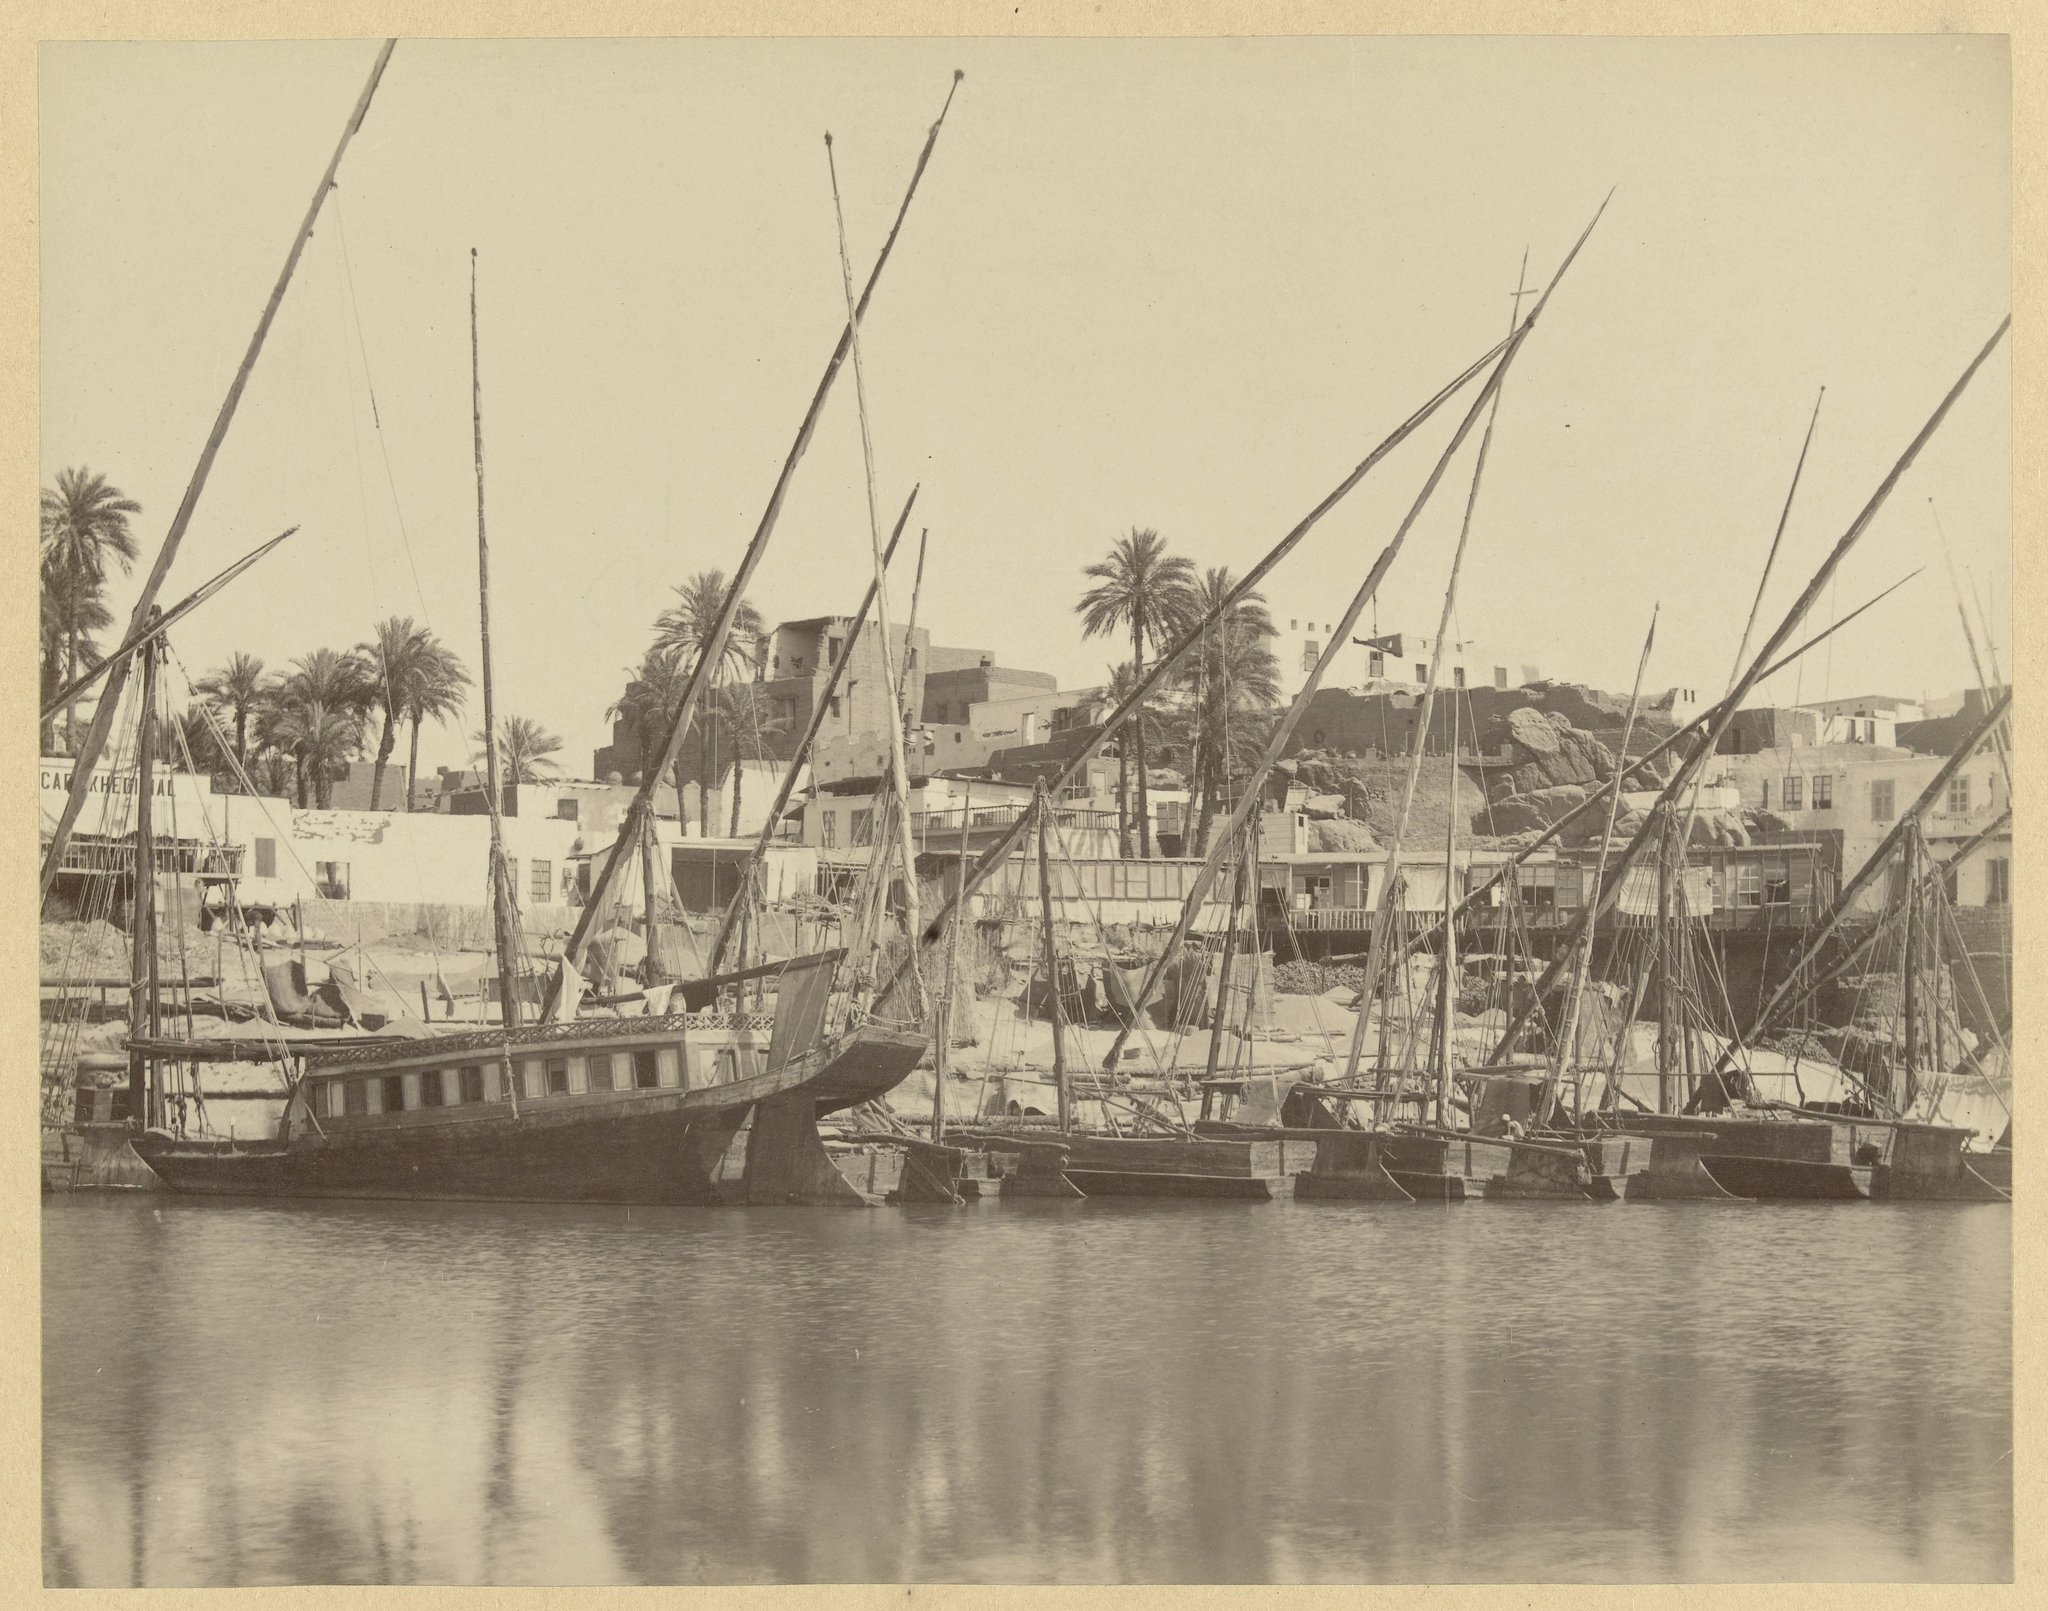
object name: photograph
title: E 95. Assouan. Opper-Egypte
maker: Anonymous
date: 1890-1895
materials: cardboard, paper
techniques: albumen print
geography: aswan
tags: harbour, river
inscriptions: check stamp: ‘Bristol/ L.M’, stamp: ‘GEMEENTELIJKE BIBLIOTHEEK/ ROTTERDAM’, title: ‘E. 95. Assouan. Opper-Egypte’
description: Onderdeel van een groep door fotograaf Richard Polak op reis verzamelde foto’s. Deze foto is samen met andere op zijn reizen verzamelde foto's tentoongesteld bij de Rotterdamsche Kunstkring (1895), Arti en Amicitiae te Amsterdam (1897-1898?) en Societeit 't Collegie te Kampen (datum vooralsnog onbekend).